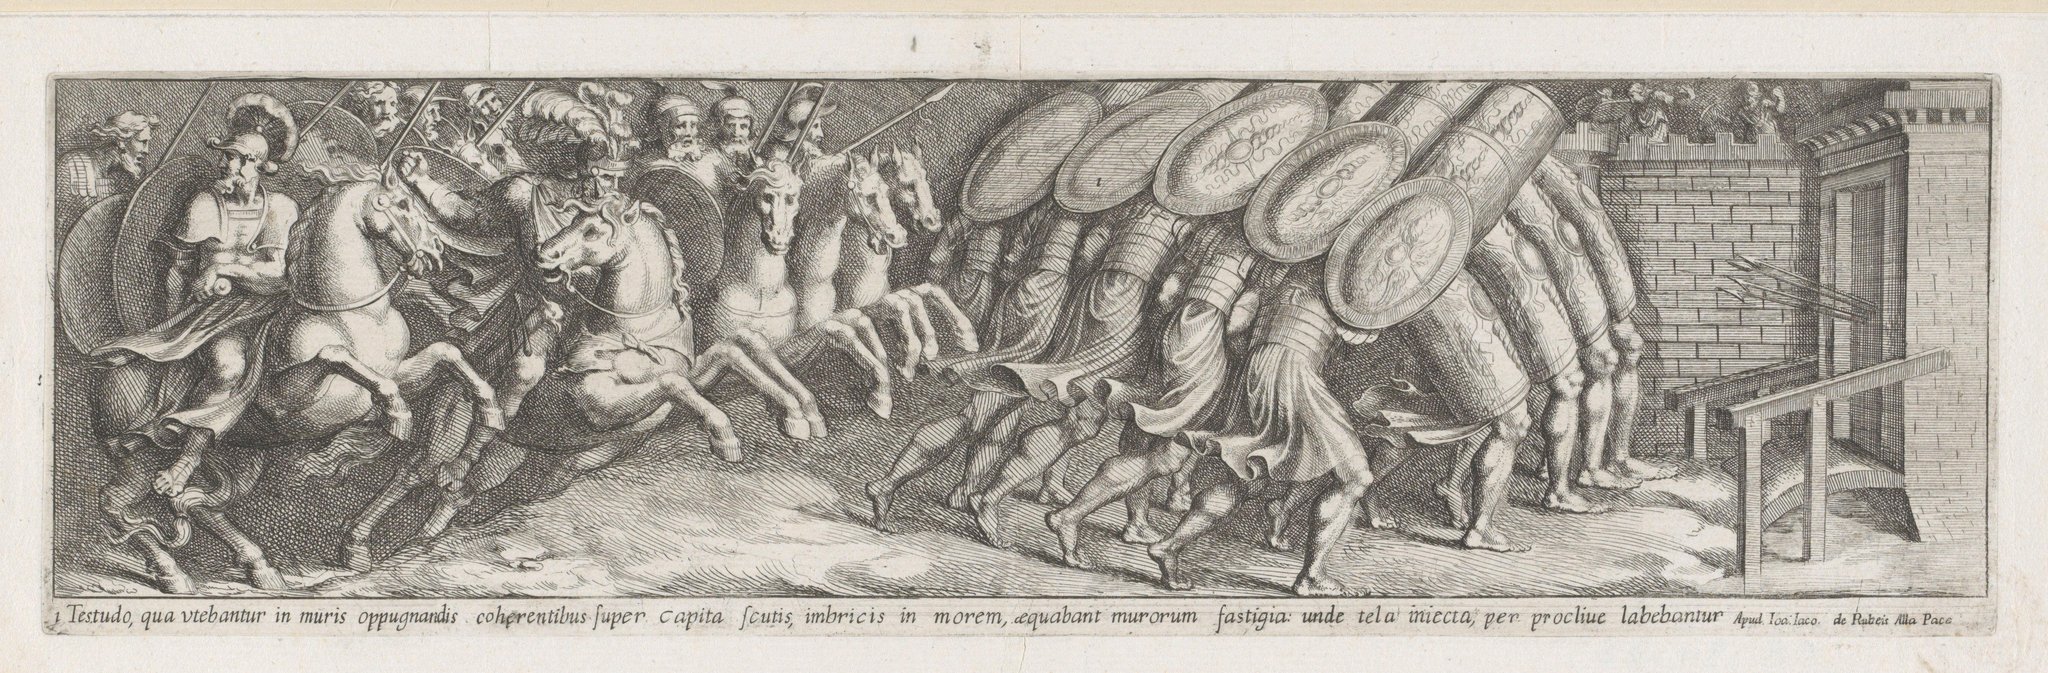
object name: print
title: Geschiedenis van keizer Constantijn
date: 1645-1700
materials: paper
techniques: engraving, etching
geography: rome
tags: battle, warfare; military affairs (+ cavalry, horsemen), the soldier; the soldier's life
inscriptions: collector's mark: Lugt 240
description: Een leger soldaten te paard en te voet bij een ommuurde stad. Legenda in de ondermarge.